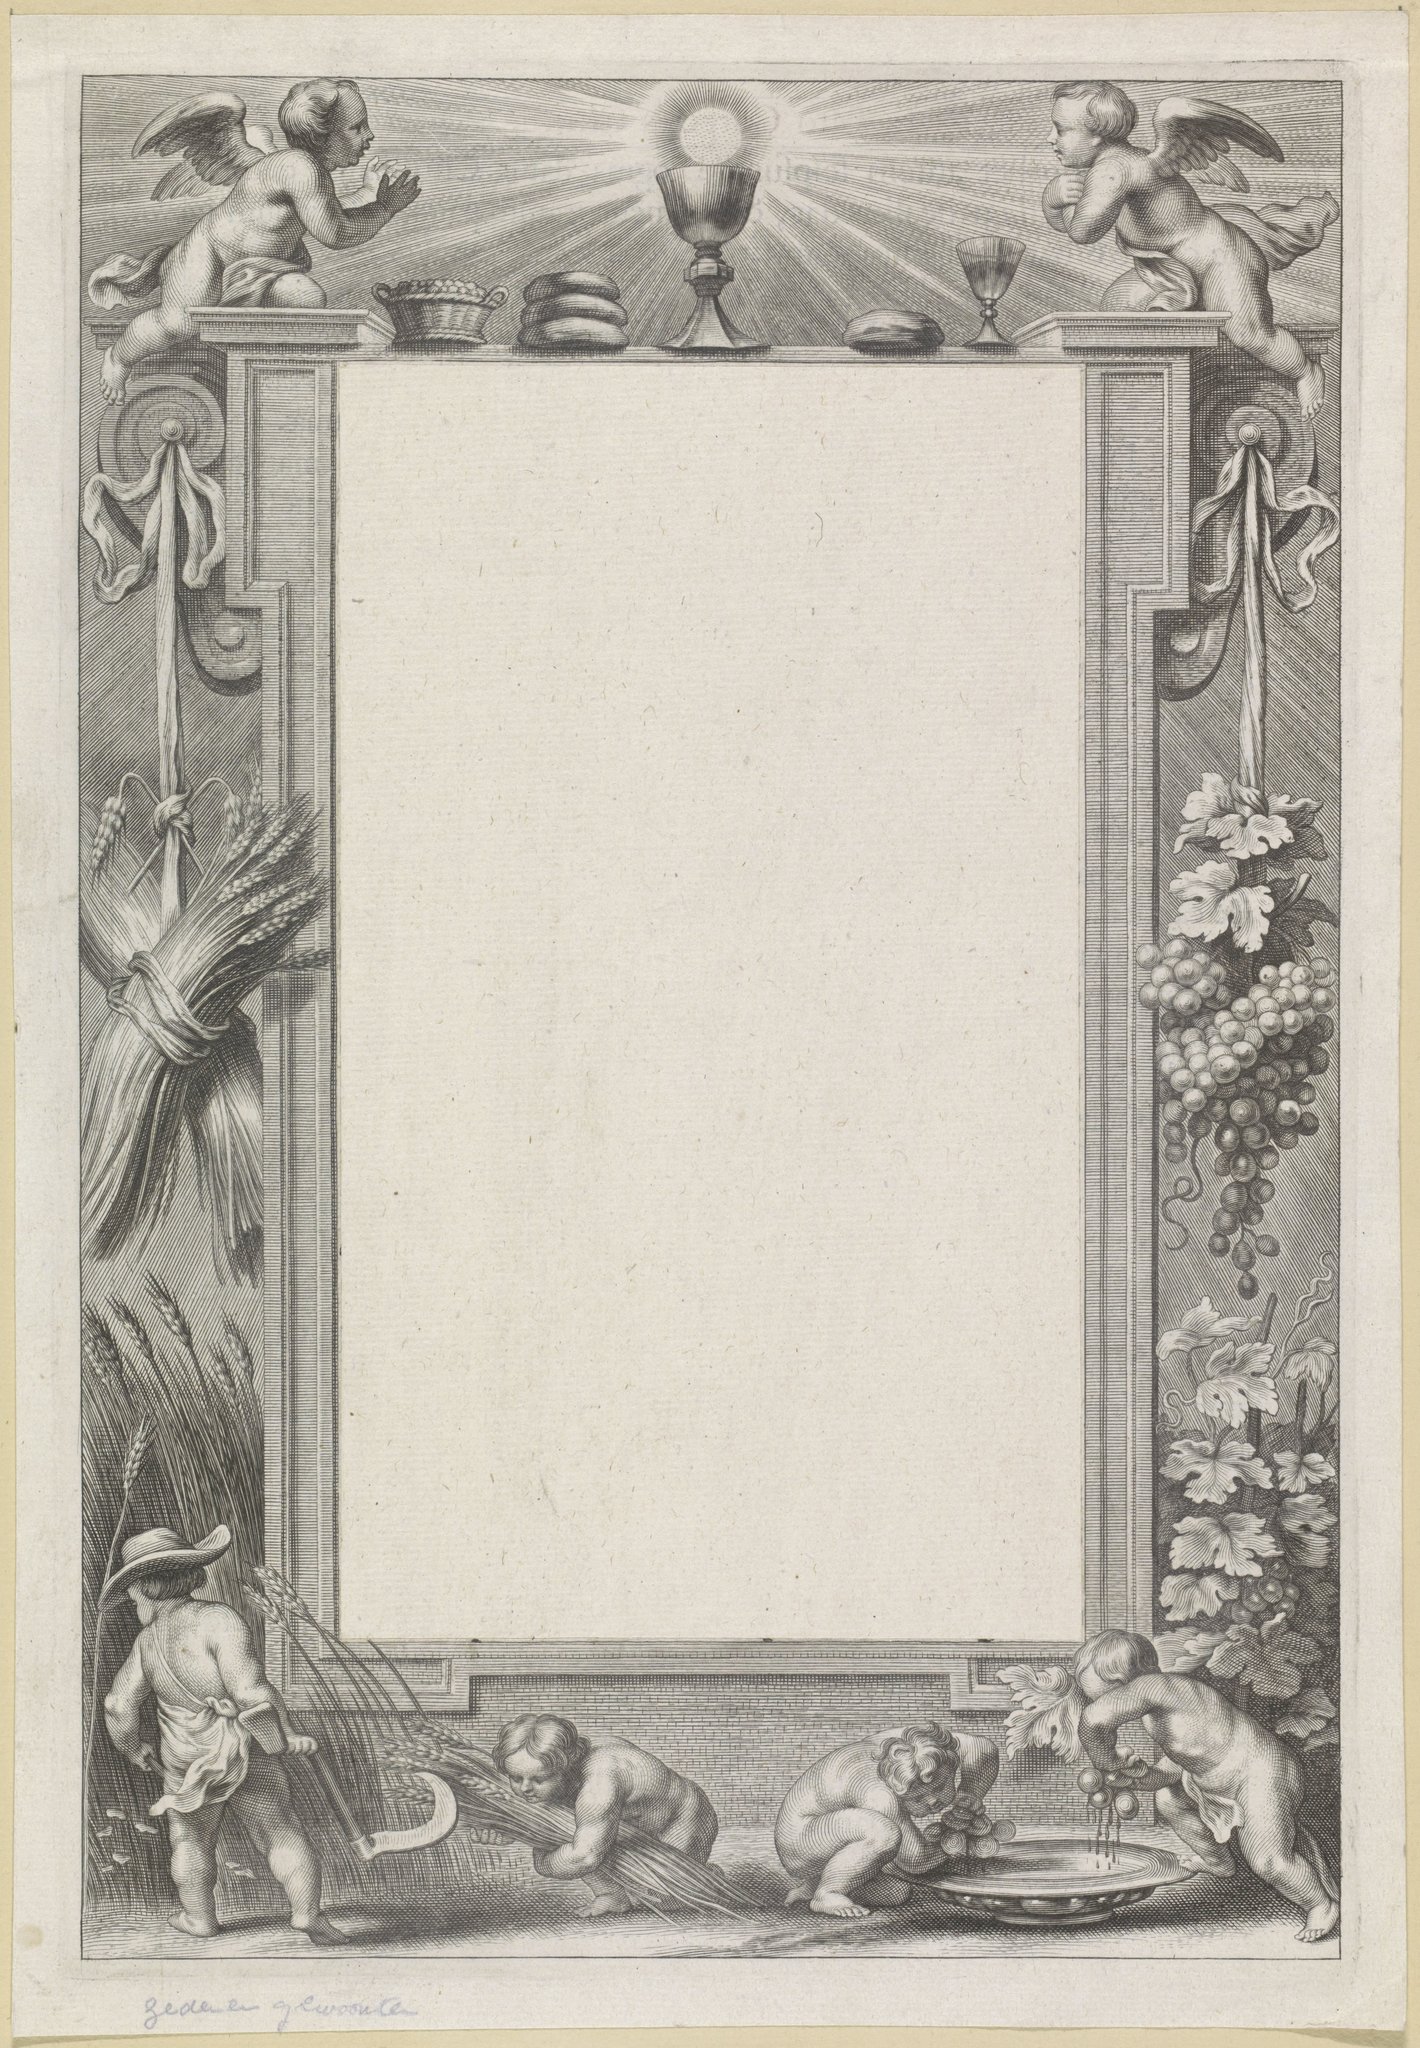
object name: print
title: Omlijsting met miskelk en hostie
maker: Anonymous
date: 1650-1750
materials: paper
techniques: engraving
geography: southern netherlands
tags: the eucharist ~ the fourth of the seven sacraments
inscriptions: collector's mark: Lugt 2228, collector's mark: Lugt 240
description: Een omlijsting met bovenaan putti die het Allerheiligste aanbidden: de miskelk en hostie. Links en rechts en onder symbolen voor de Eucharistie. Links putti die graan voor het brood oogsten. Rechts putti die druiven boven een schaal uitpersen.